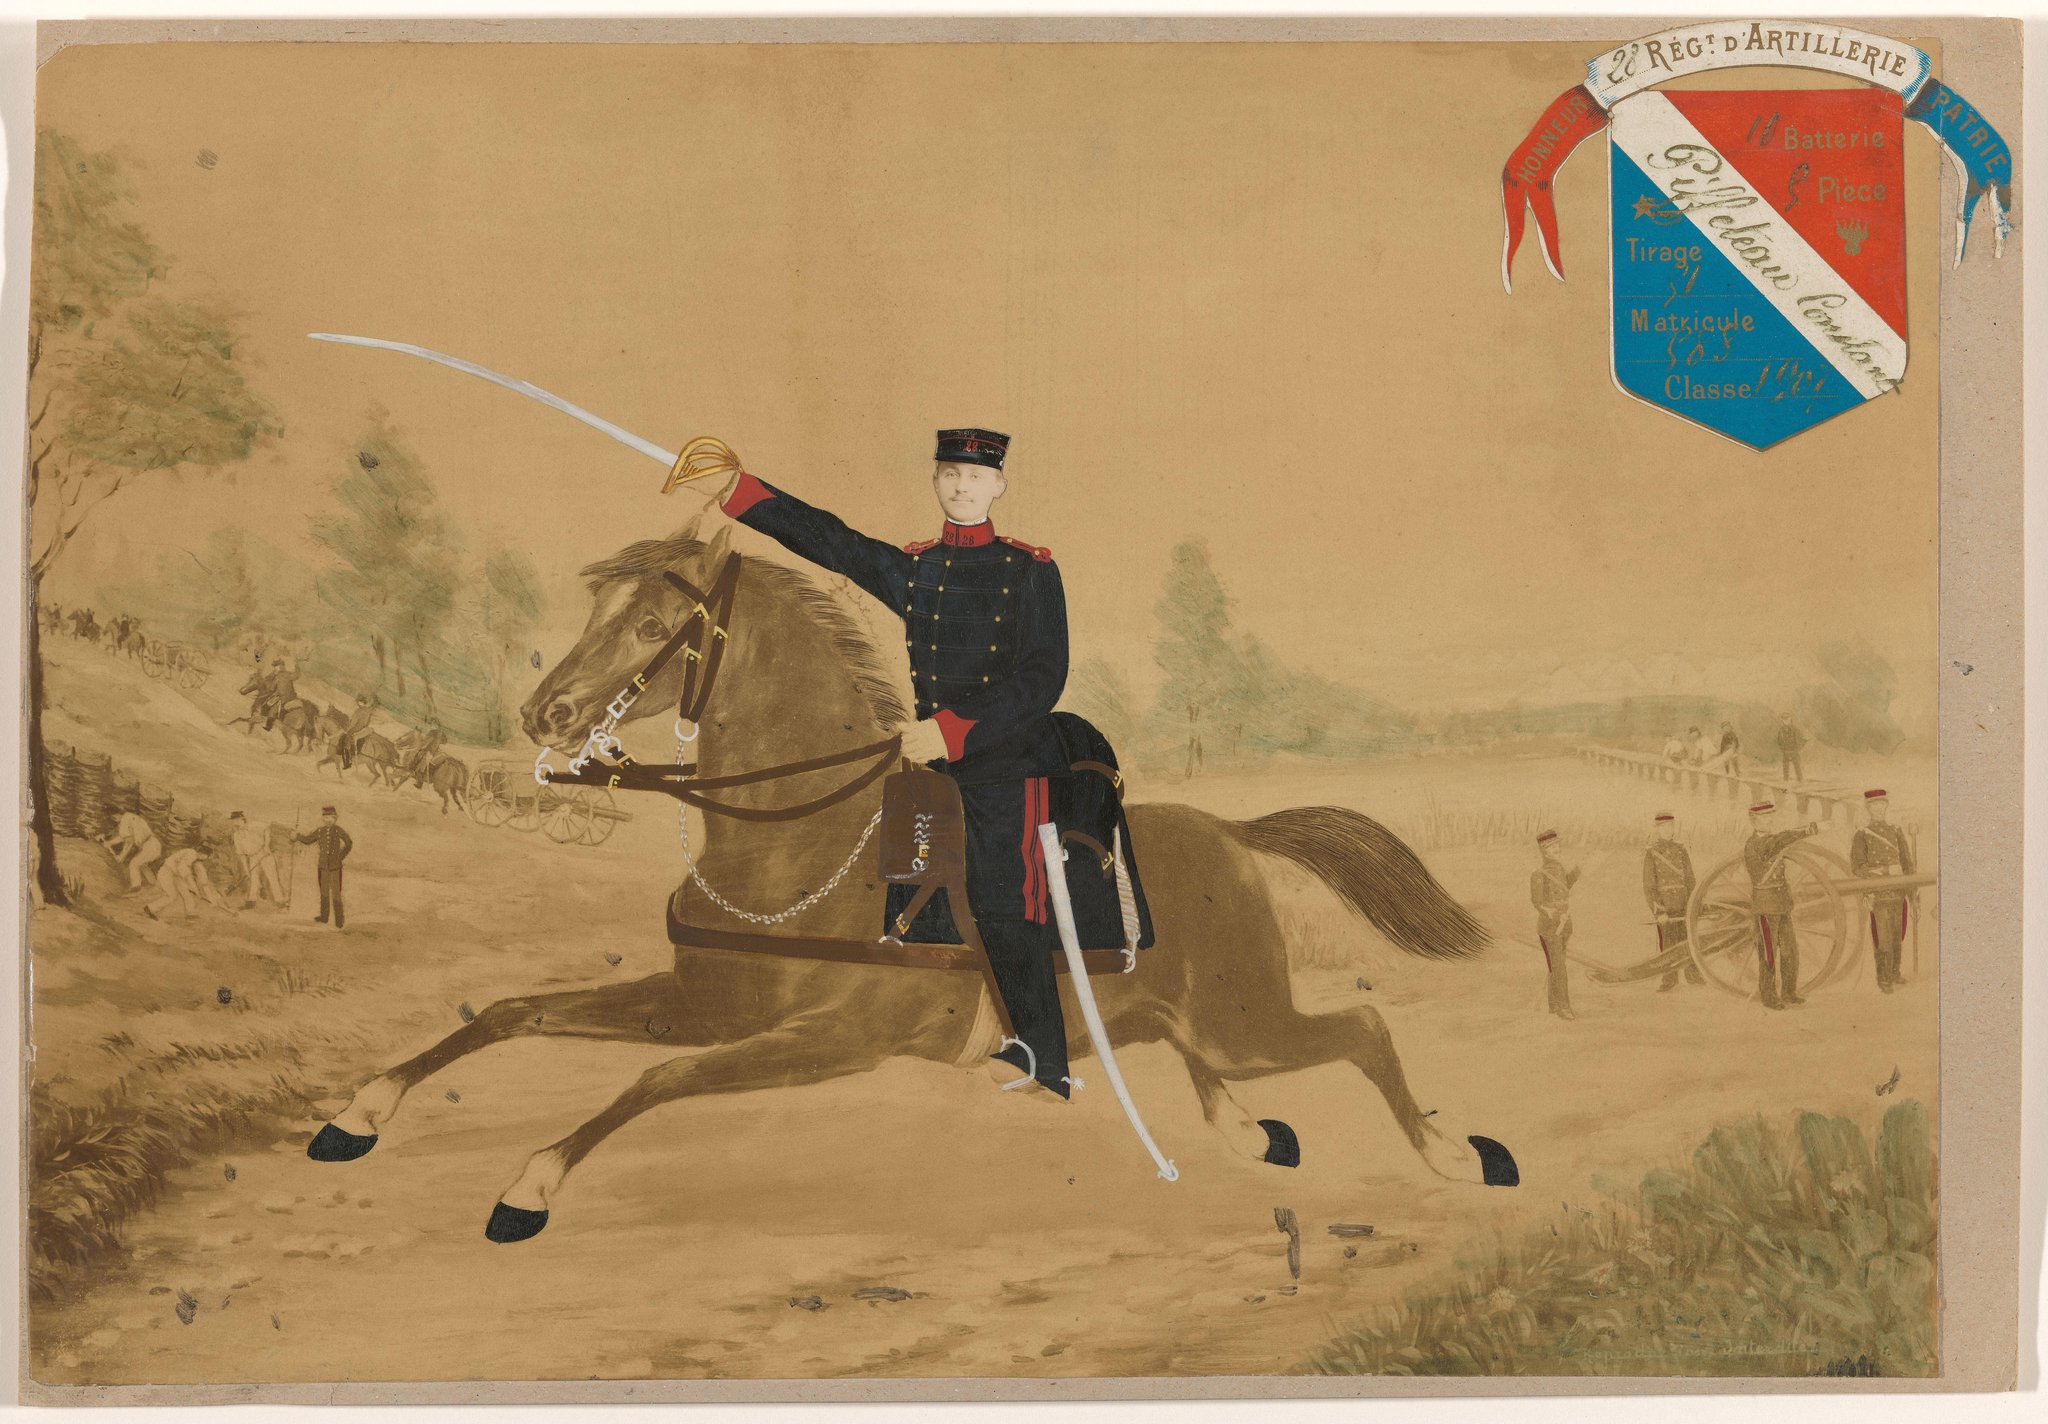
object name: photograph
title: Four Portraits of a Soldier on Horseback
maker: Anonymous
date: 1891-1913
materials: cardboard, paint, photographic support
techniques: albumen print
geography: france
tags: riding a horse, ass, or mule; rider, horseman, warfare; military affairs (+ cavalry, horsemen), warfare; military affairs (+ artillery)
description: Militair van het 3e régiment d'artillerie. Onderdeel van 7 portretten van Franse militairen uit verschillende regimenten en jaren.